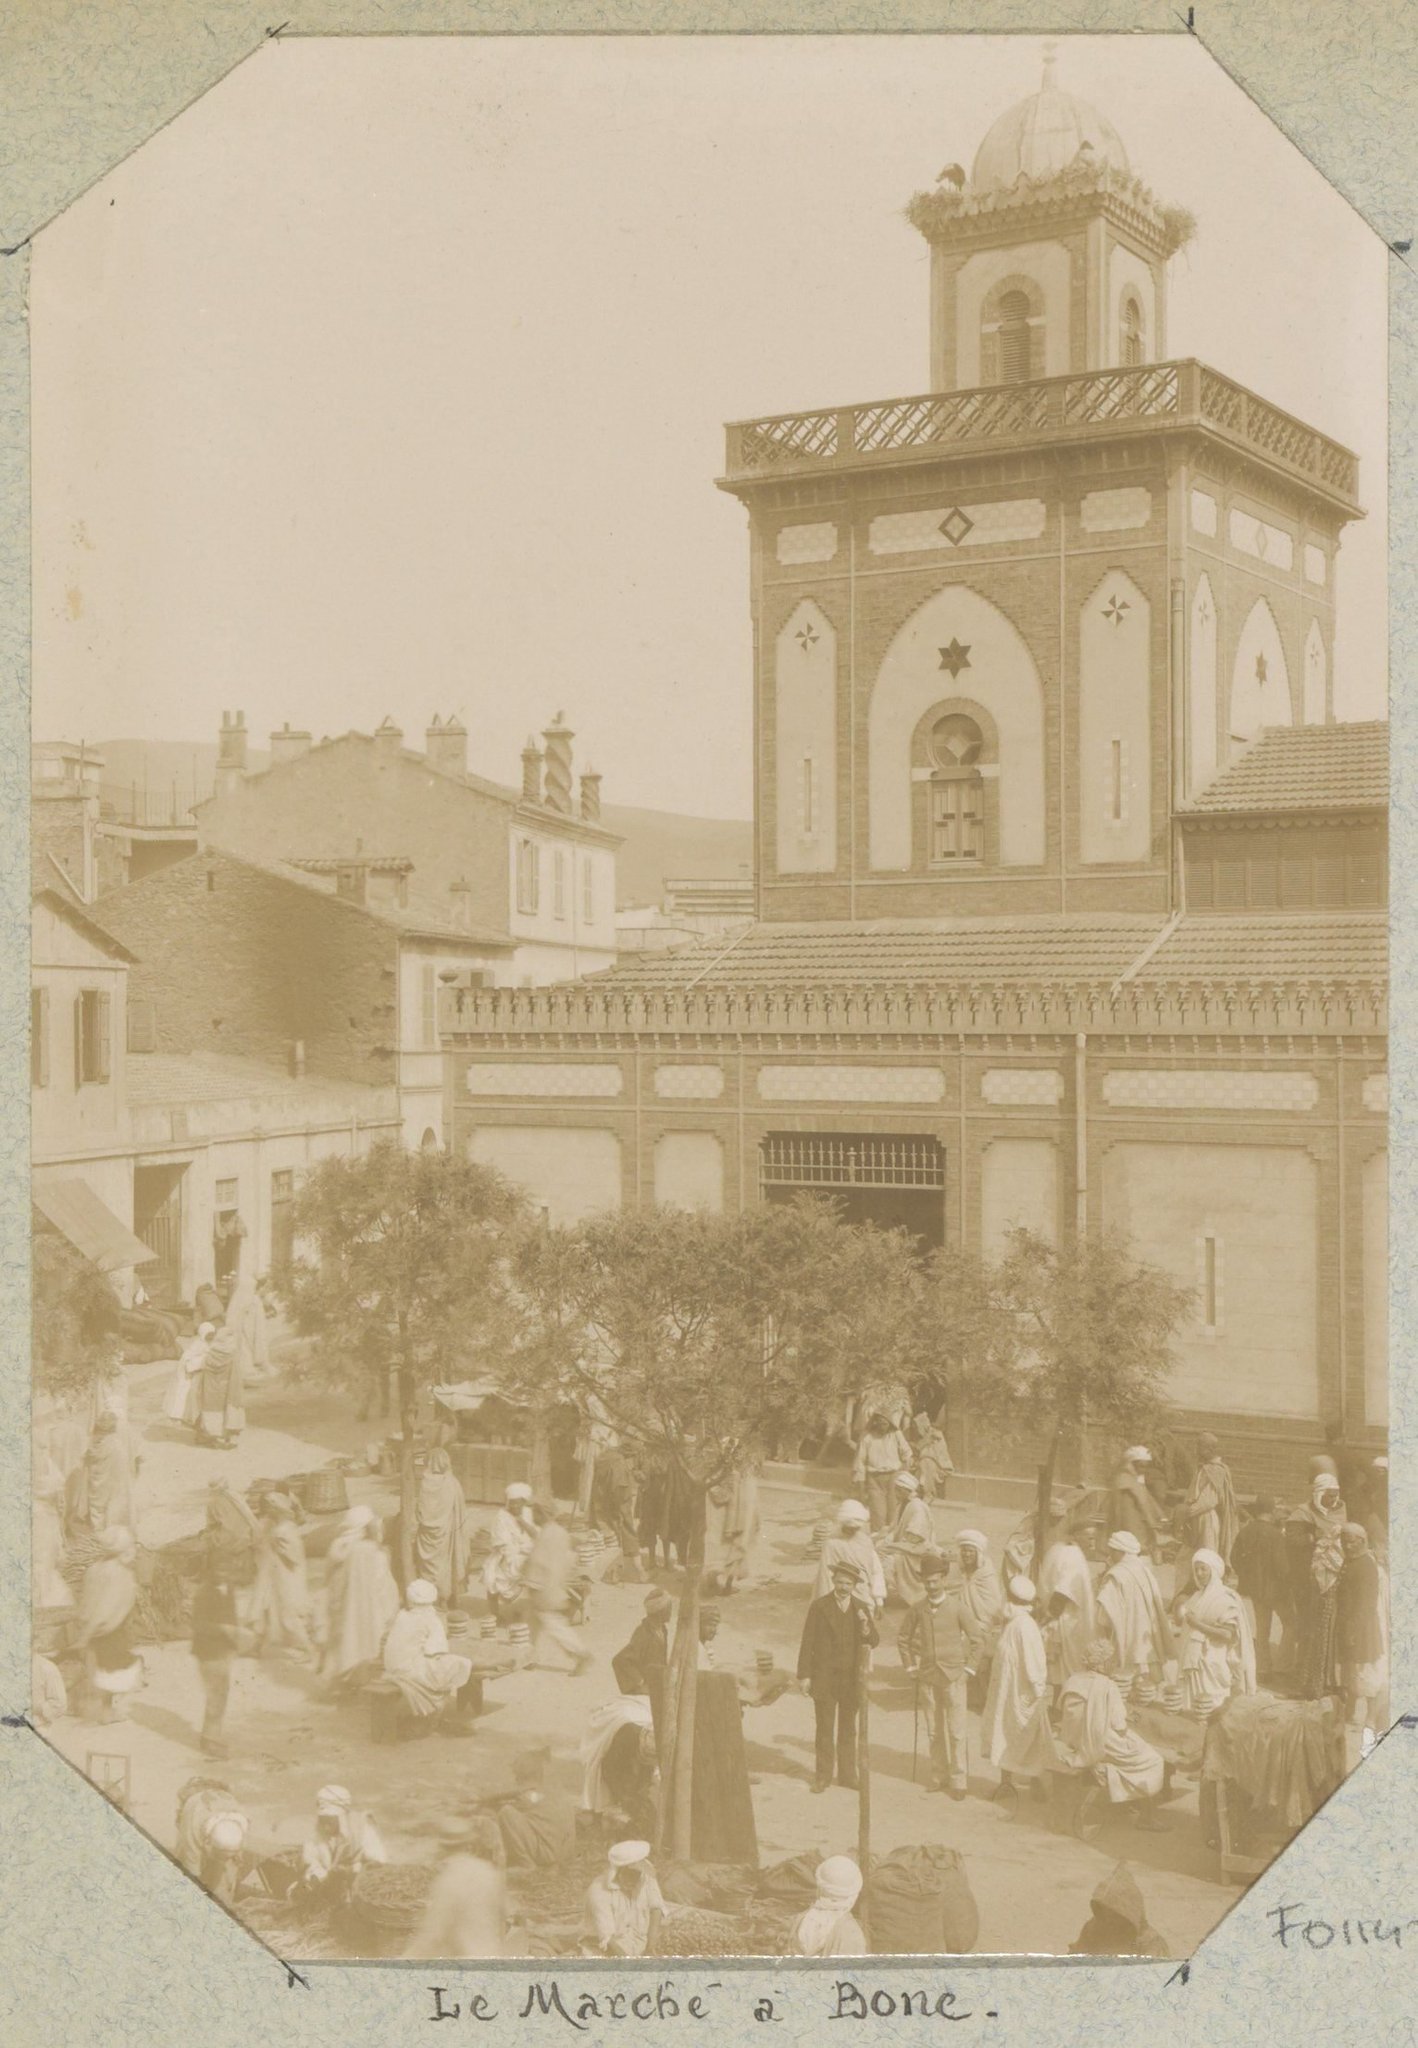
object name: album leaf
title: Markt in Bône (Algerije)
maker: Anonymous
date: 1890-1900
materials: paper, photographic support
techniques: daylight paper print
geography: bône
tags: market, goat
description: Onderdeel van Album van een Franse amateur met foto's van Frankrijk, Algerije, Palmyra, de Wereldtentoonstelling van 1900 en van bekende Fransen.